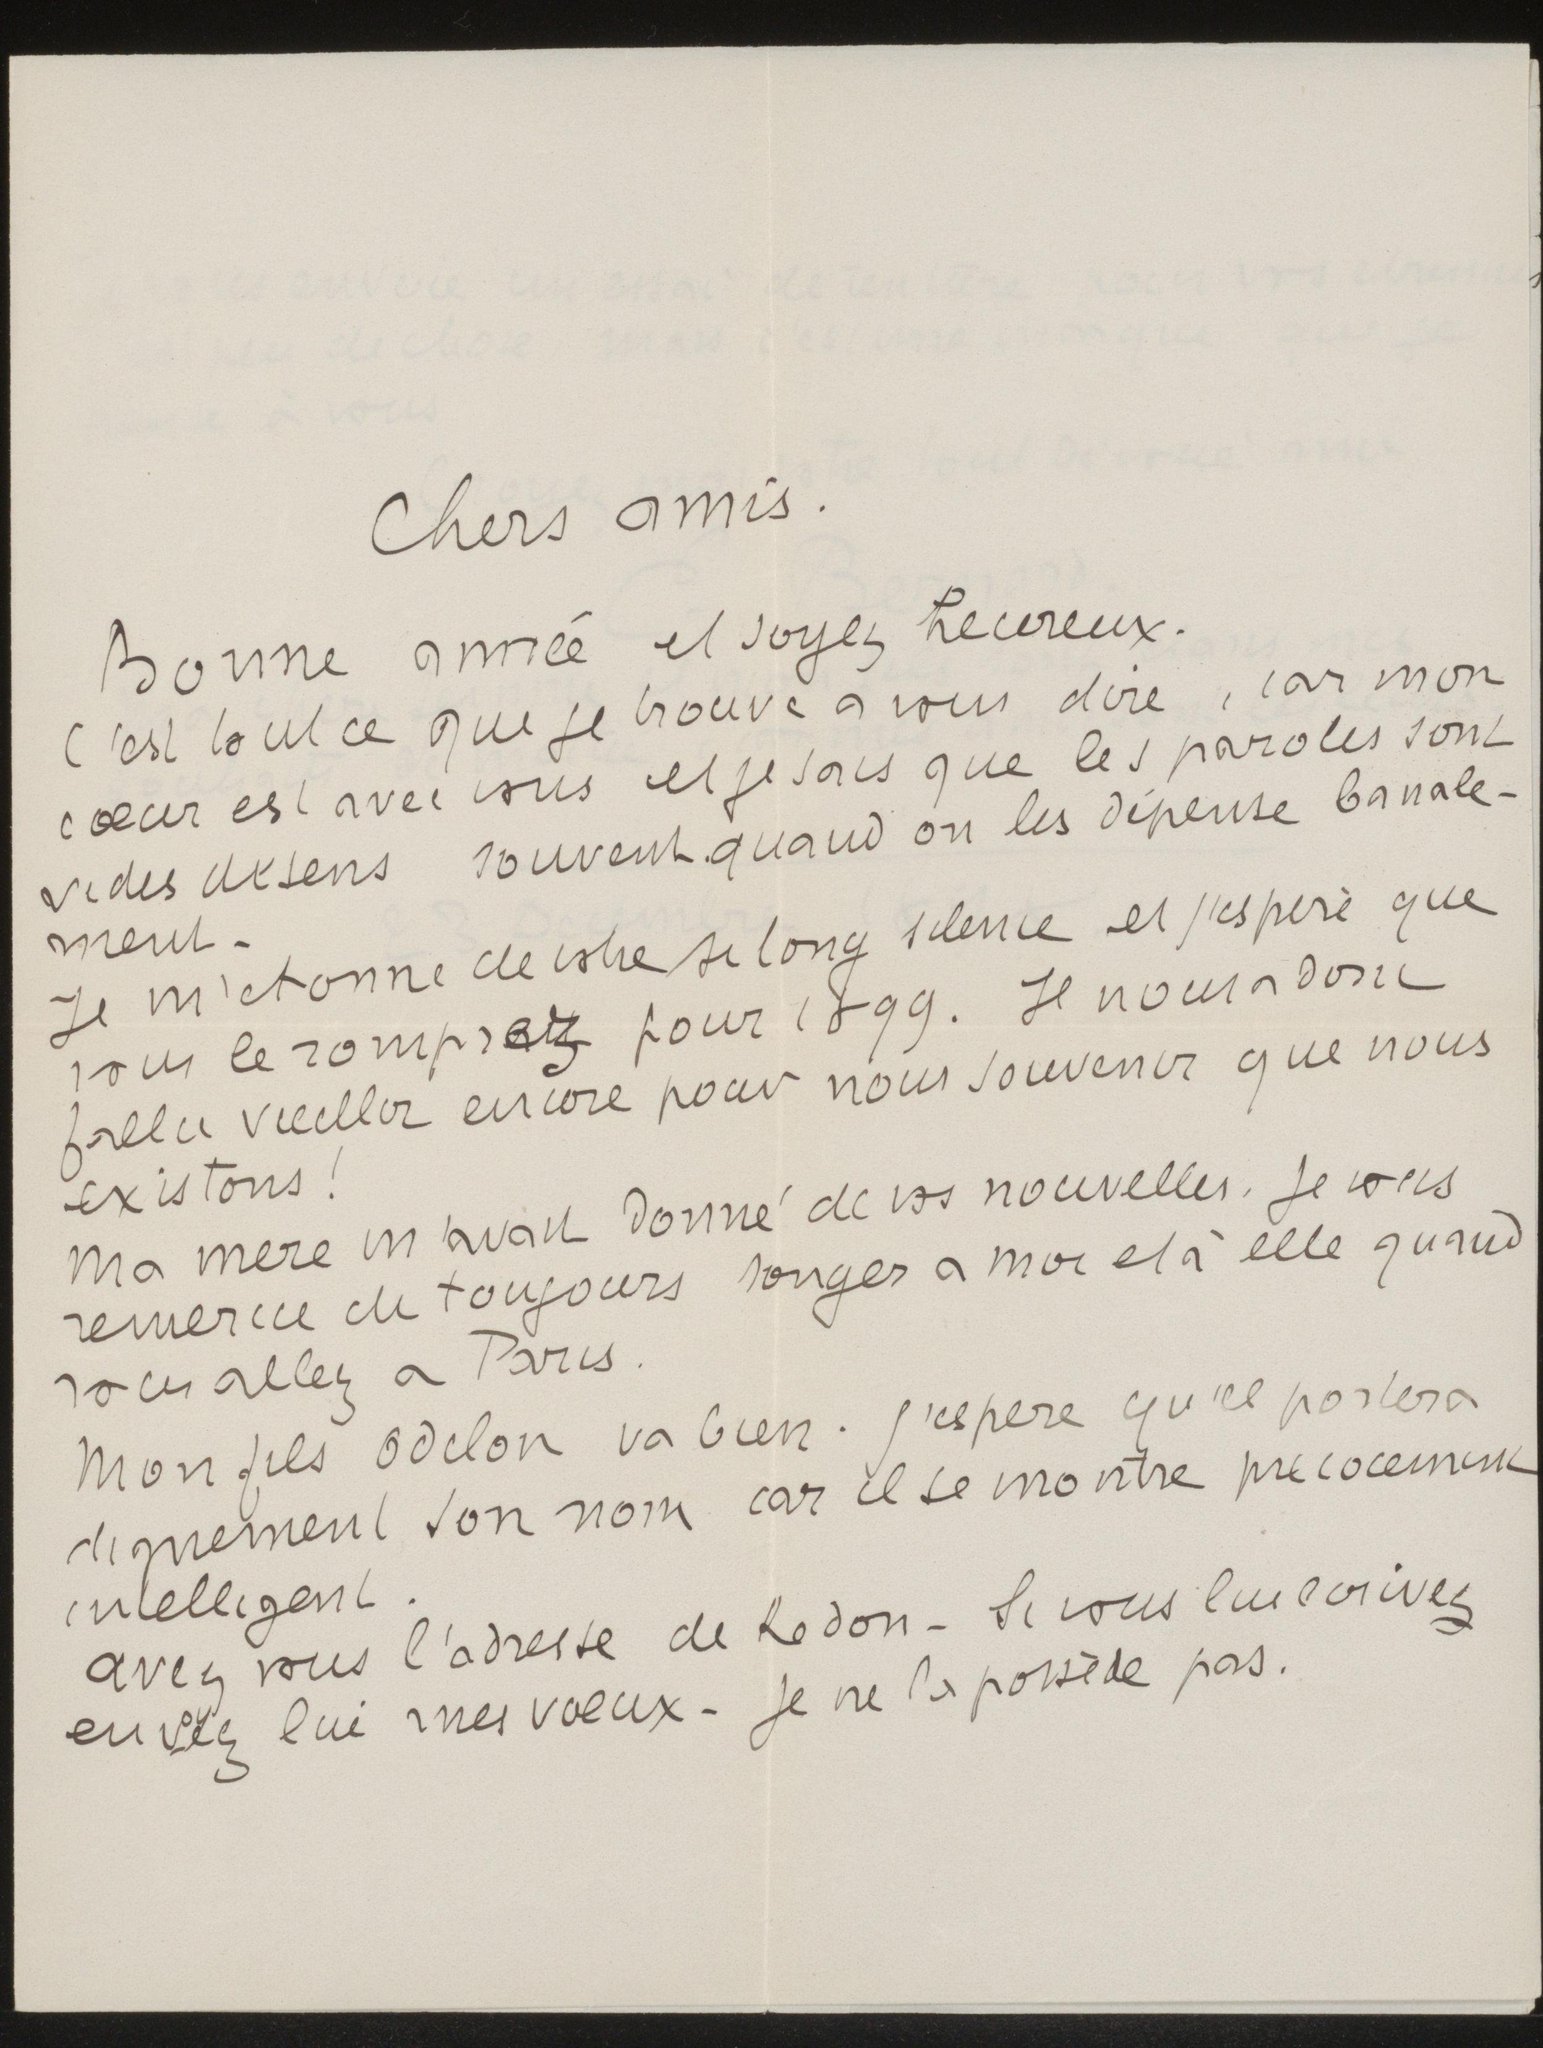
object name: letter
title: Brief aan Andries Bonger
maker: émile bernard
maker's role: print maker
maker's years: 1868-1941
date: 1898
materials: ink, paper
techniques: pen, writing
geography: cairo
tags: draughtsman, odilon redon, amsterdam, andries bonger, family life, paris